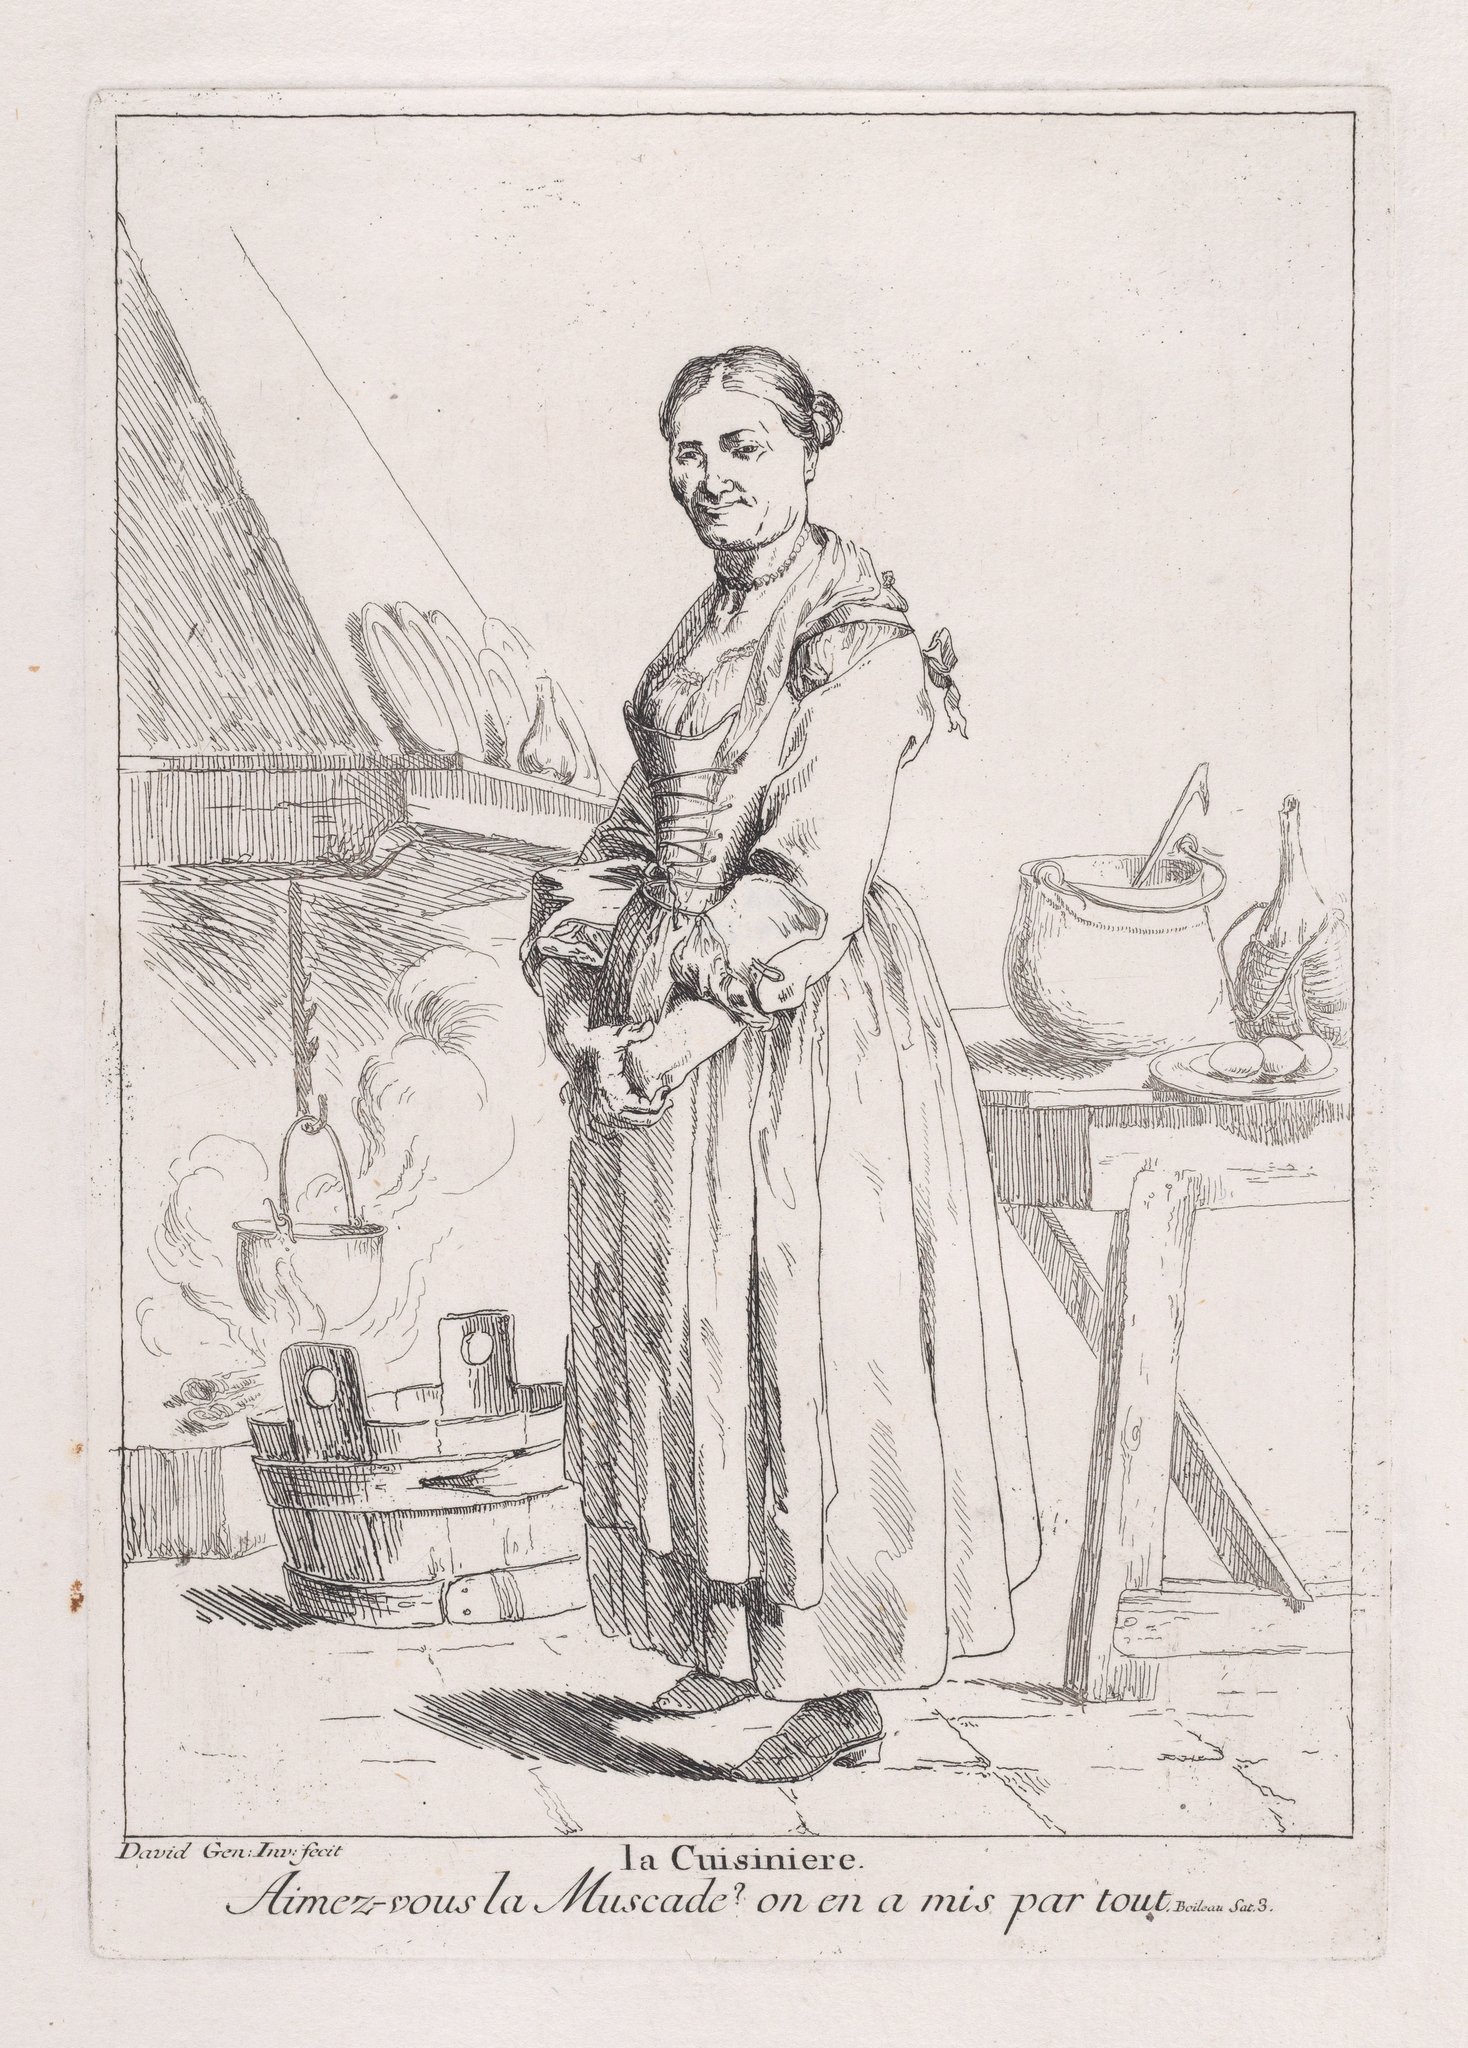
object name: print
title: The Cook, from "Divers Portraits"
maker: giovanni david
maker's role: artist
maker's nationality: italian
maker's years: 1749-1790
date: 1775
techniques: etching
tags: women,cooking